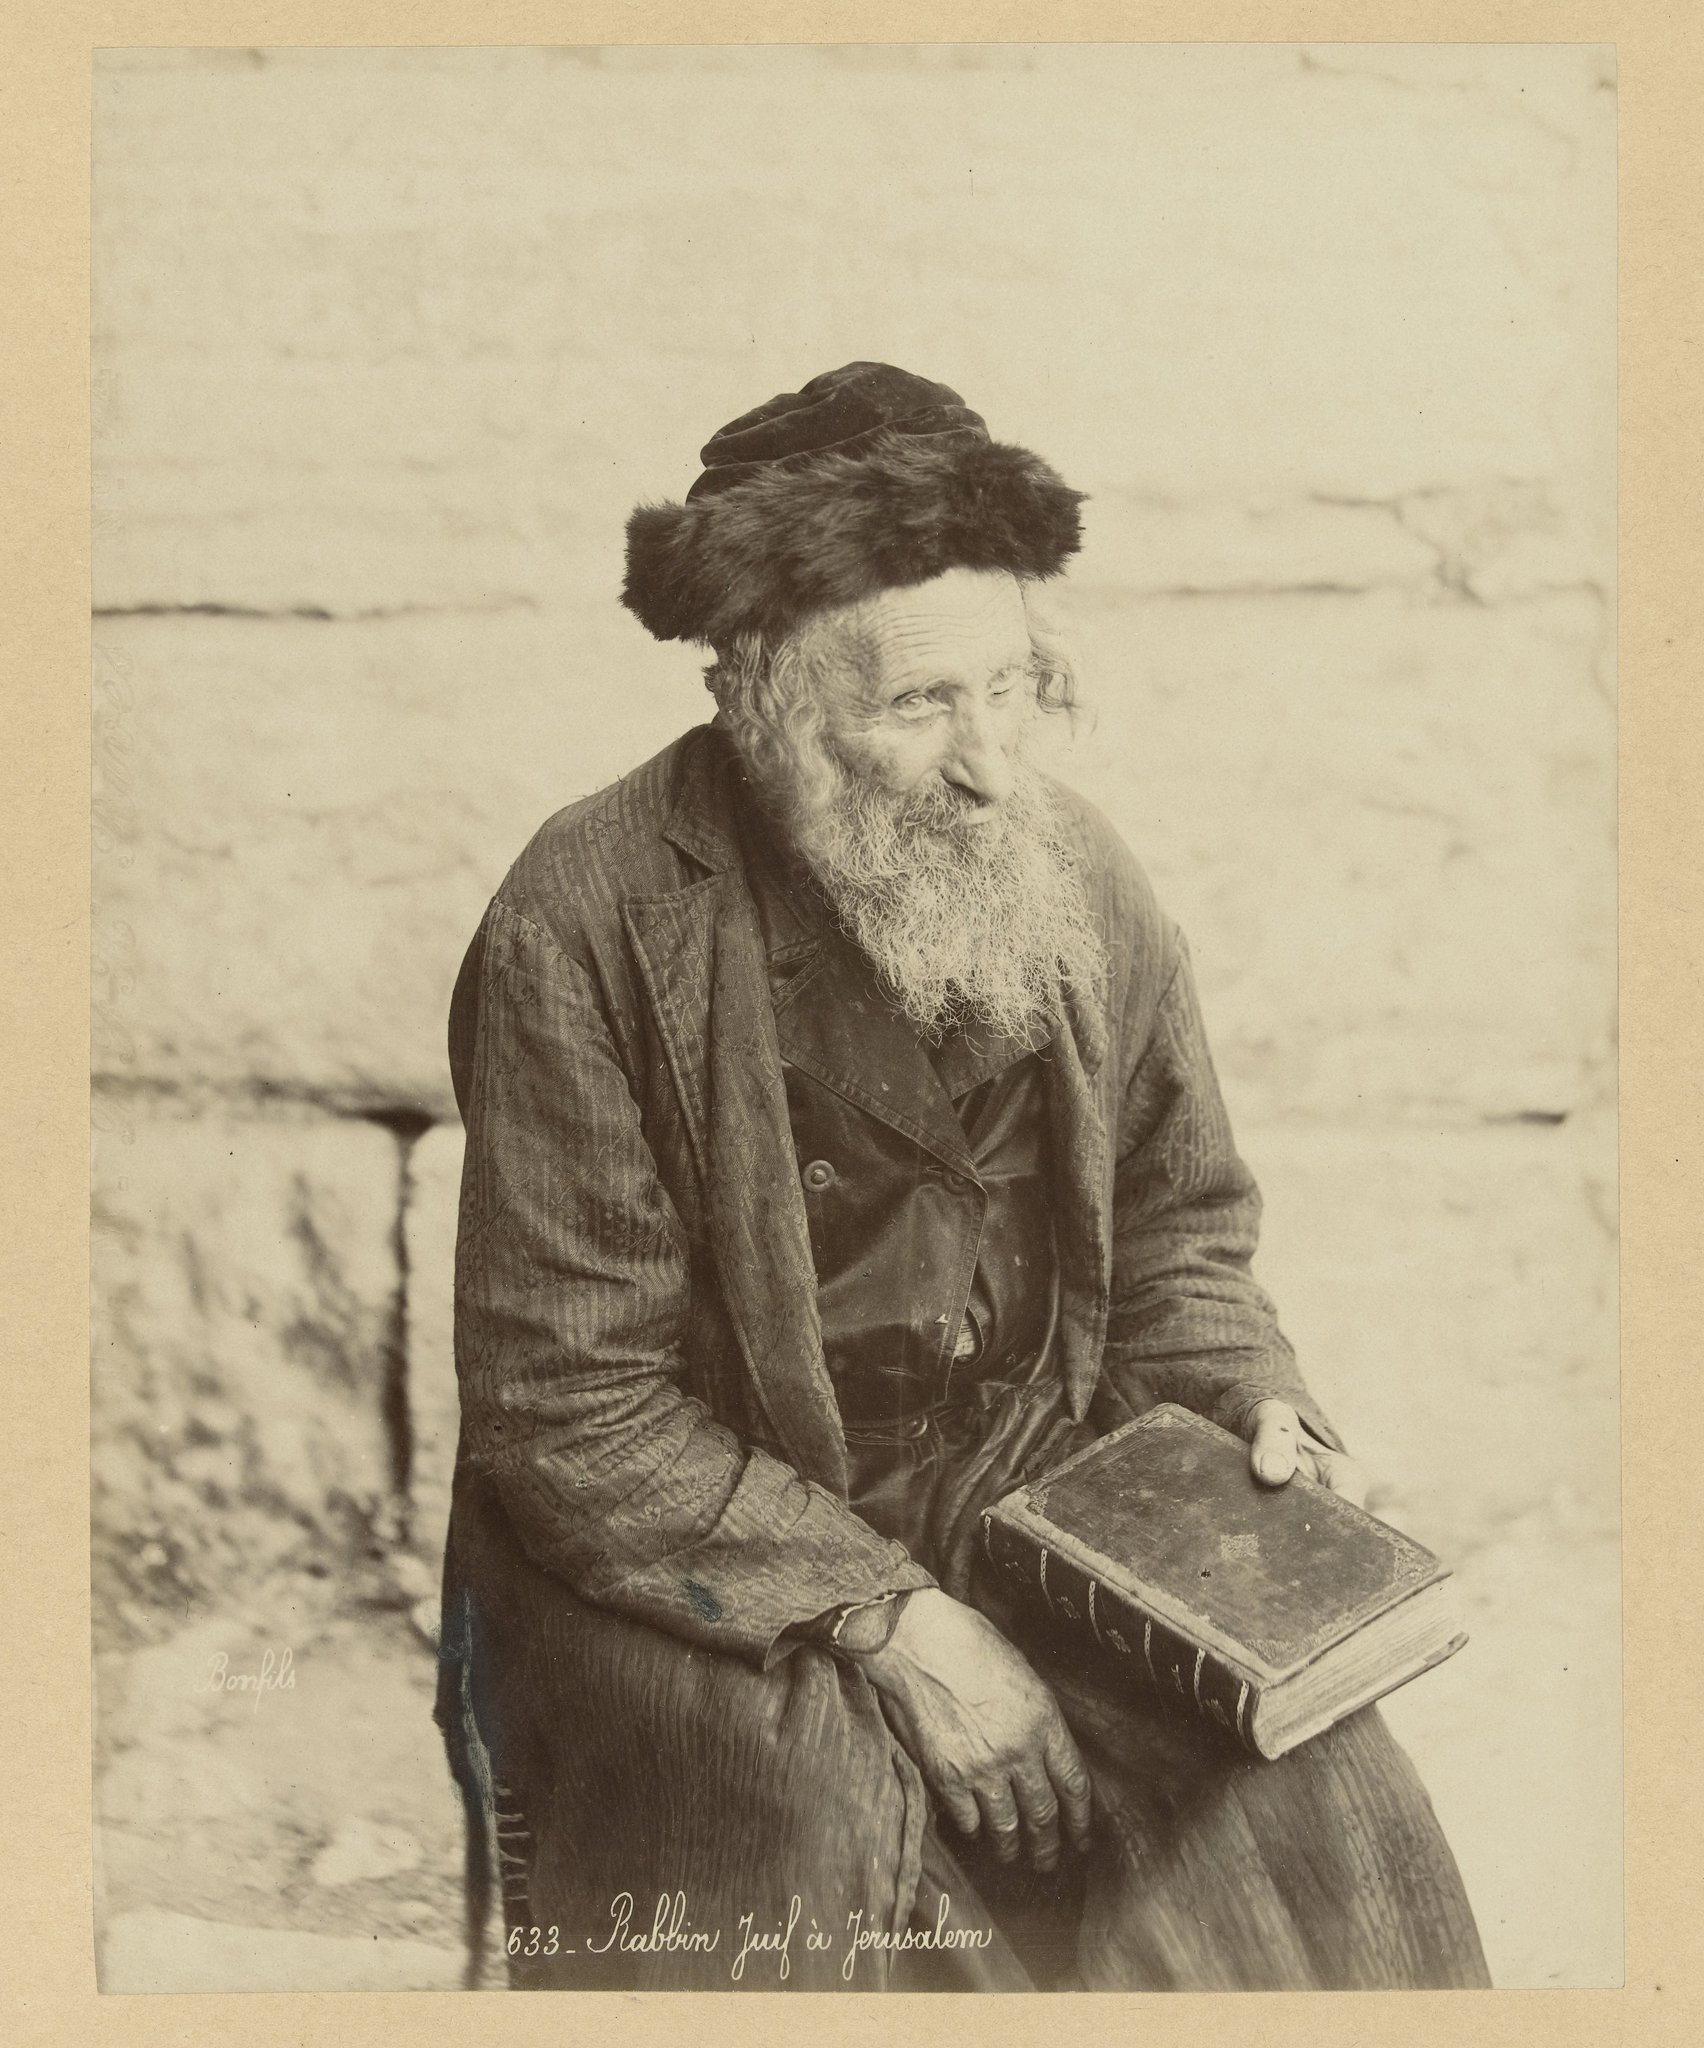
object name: photograph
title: Portret van een onbekende rabbijn, Jeruzalem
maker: félix bonfils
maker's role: fotograaf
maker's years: 1831-1885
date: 1867-1877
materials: cardboard, paper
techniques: albumen print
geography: jerusalem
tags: rabbi, historical persons not known by name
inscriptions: title: ‘S 36. Een joodsch rabbijn. Jeruzalem.’, number: ‘633’, watermark: ‘T & M. BFK Rives No 74’, stamp: ‘Gemeentelijke bibliotheek/ Rotterdam’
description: Onderdeel van een groep door fotograaf Richard Polak op reis verzamelde foto’s. Deze foto is samen met andere op zijn reizen verzamelde foto's tentoongesteld bij de Rotterdamsche Kunstkring (1895), Arti en Amicitiae te Amsterdam (1897-1898?) en Societeit 't Collegie te Kampen (datum vooralsnog onbekend).